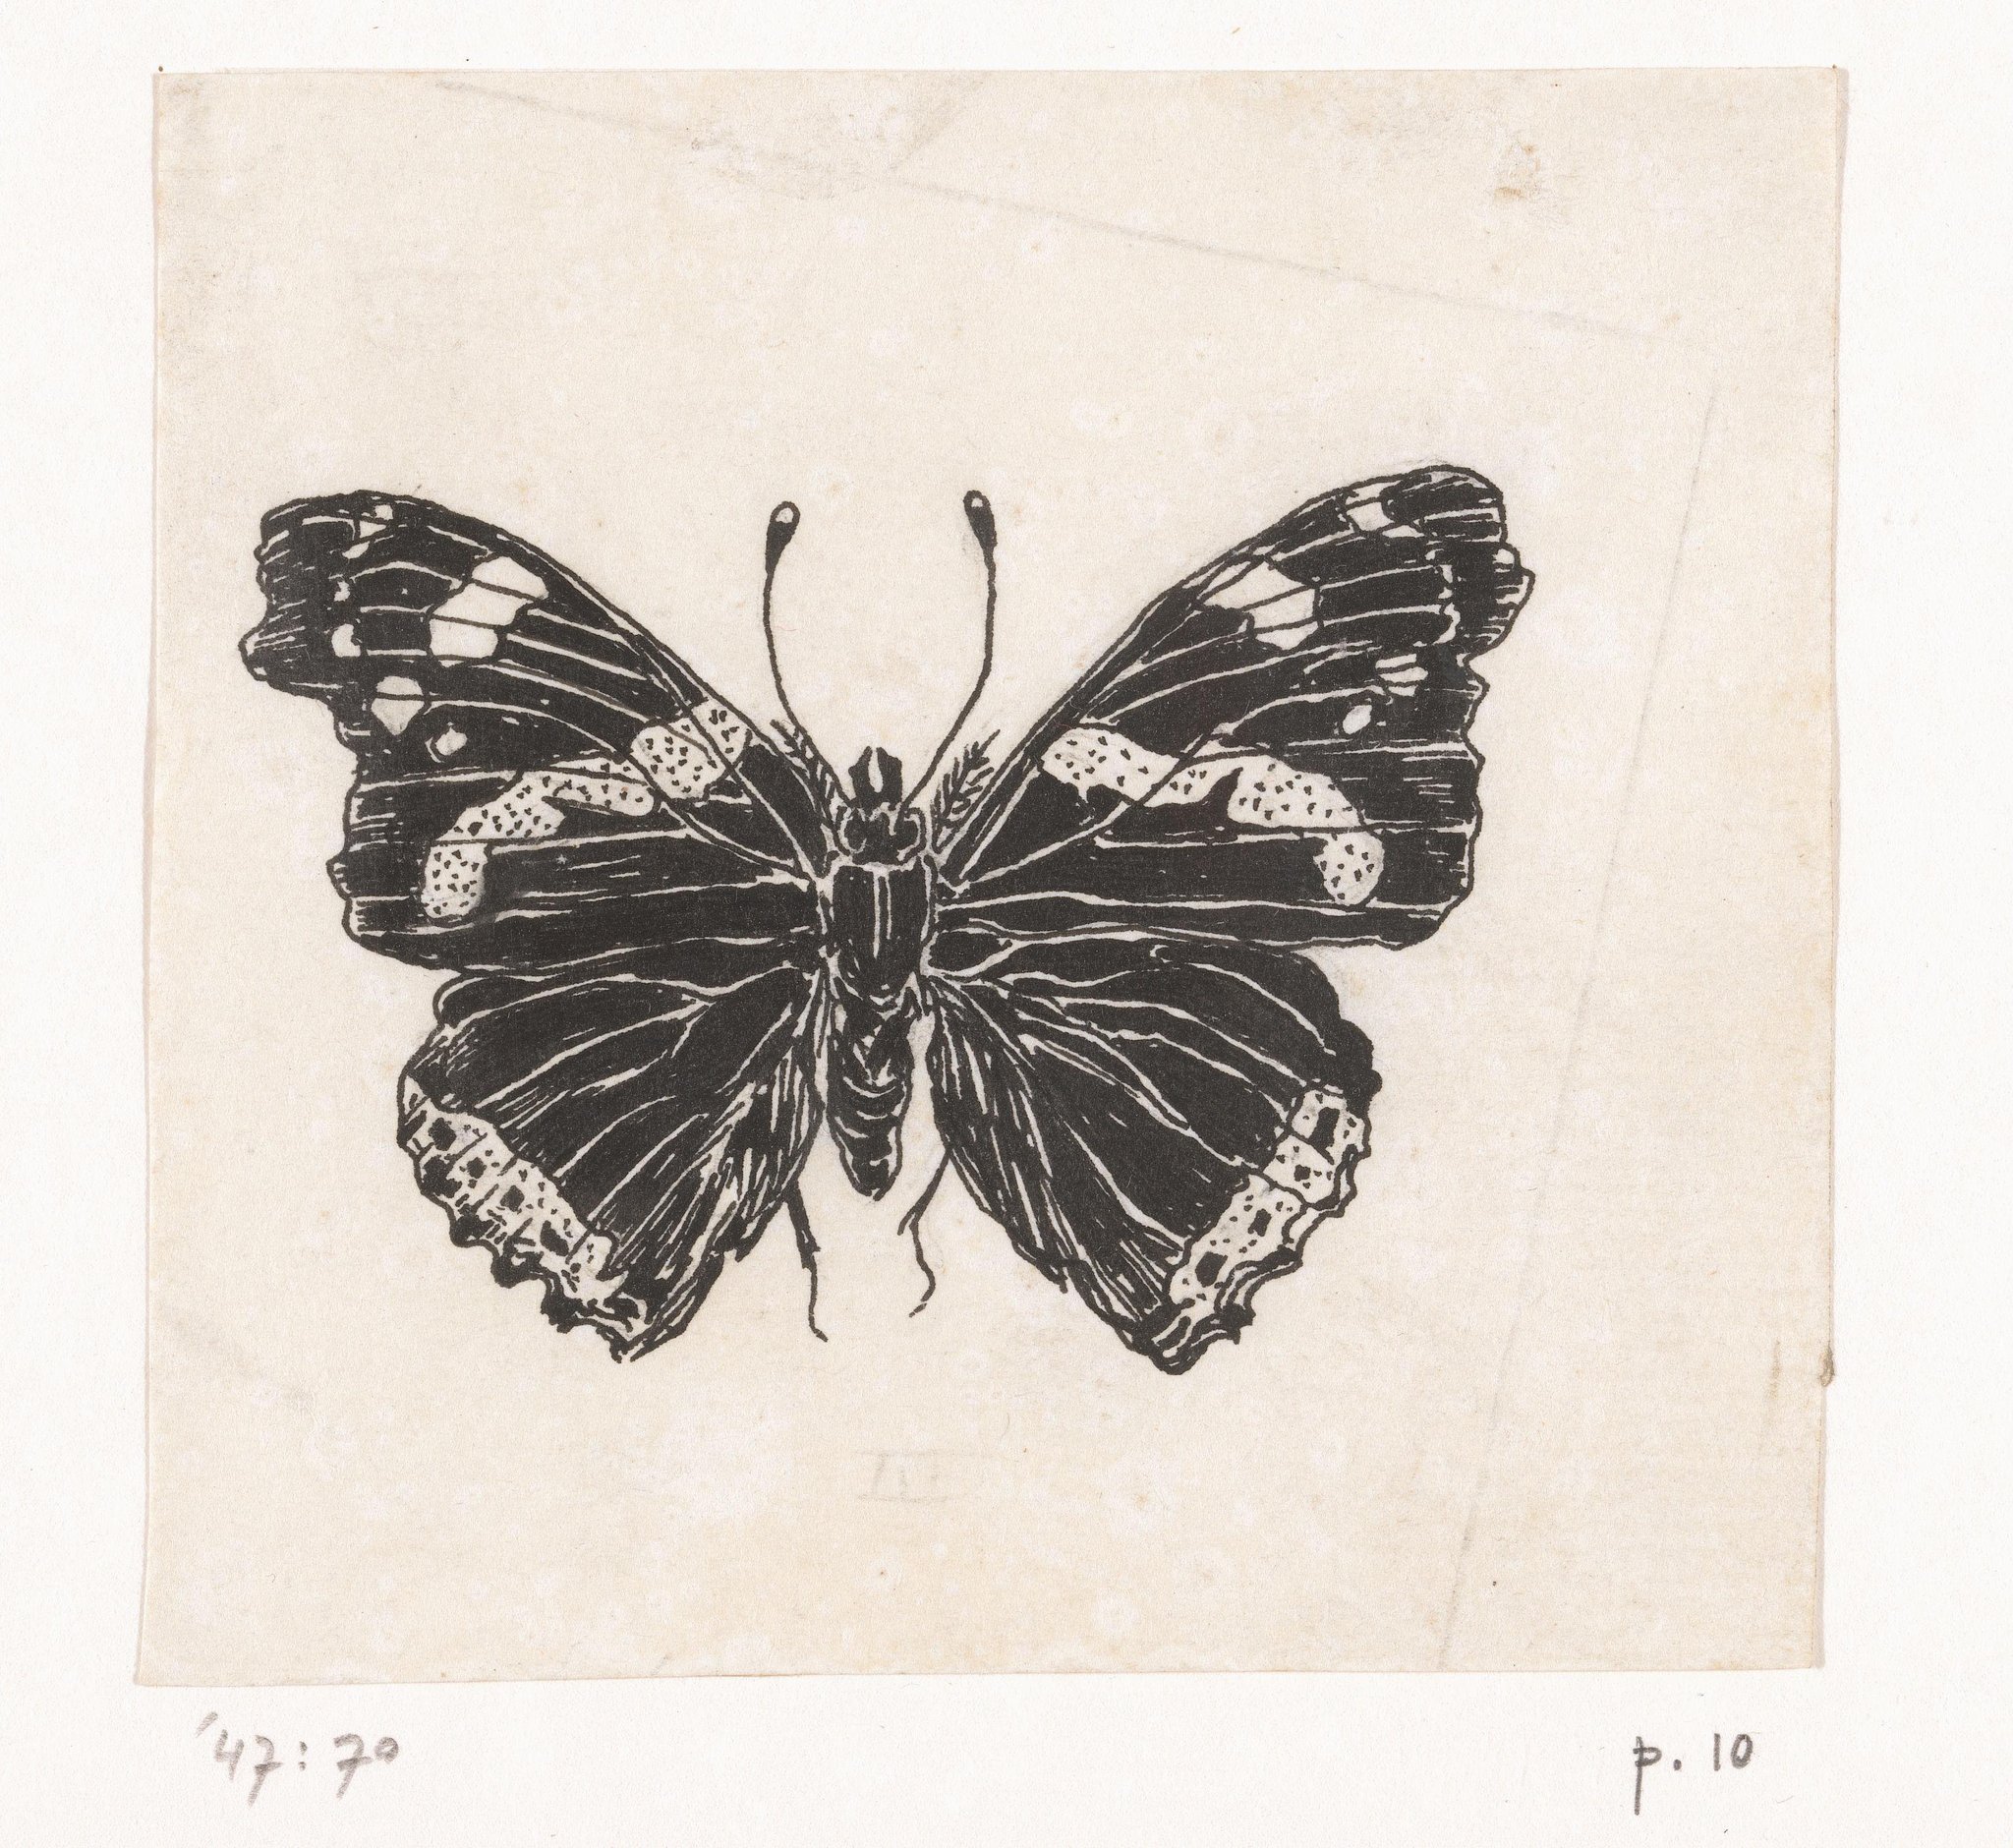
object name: drawing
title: Schoenlapper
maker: willem wenckebach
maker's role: designer, draughtsman, painter, print maker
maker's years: 1860-1937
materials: ink, paper, pencil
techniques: pen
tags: insects: butterfly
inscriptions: collector's mark: Lugt 2228a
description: Ontwerp voor: Knappert, Emilie C. Kijkjes in de plantenwereld. Loman & Funke: Amsterdam, 1893.